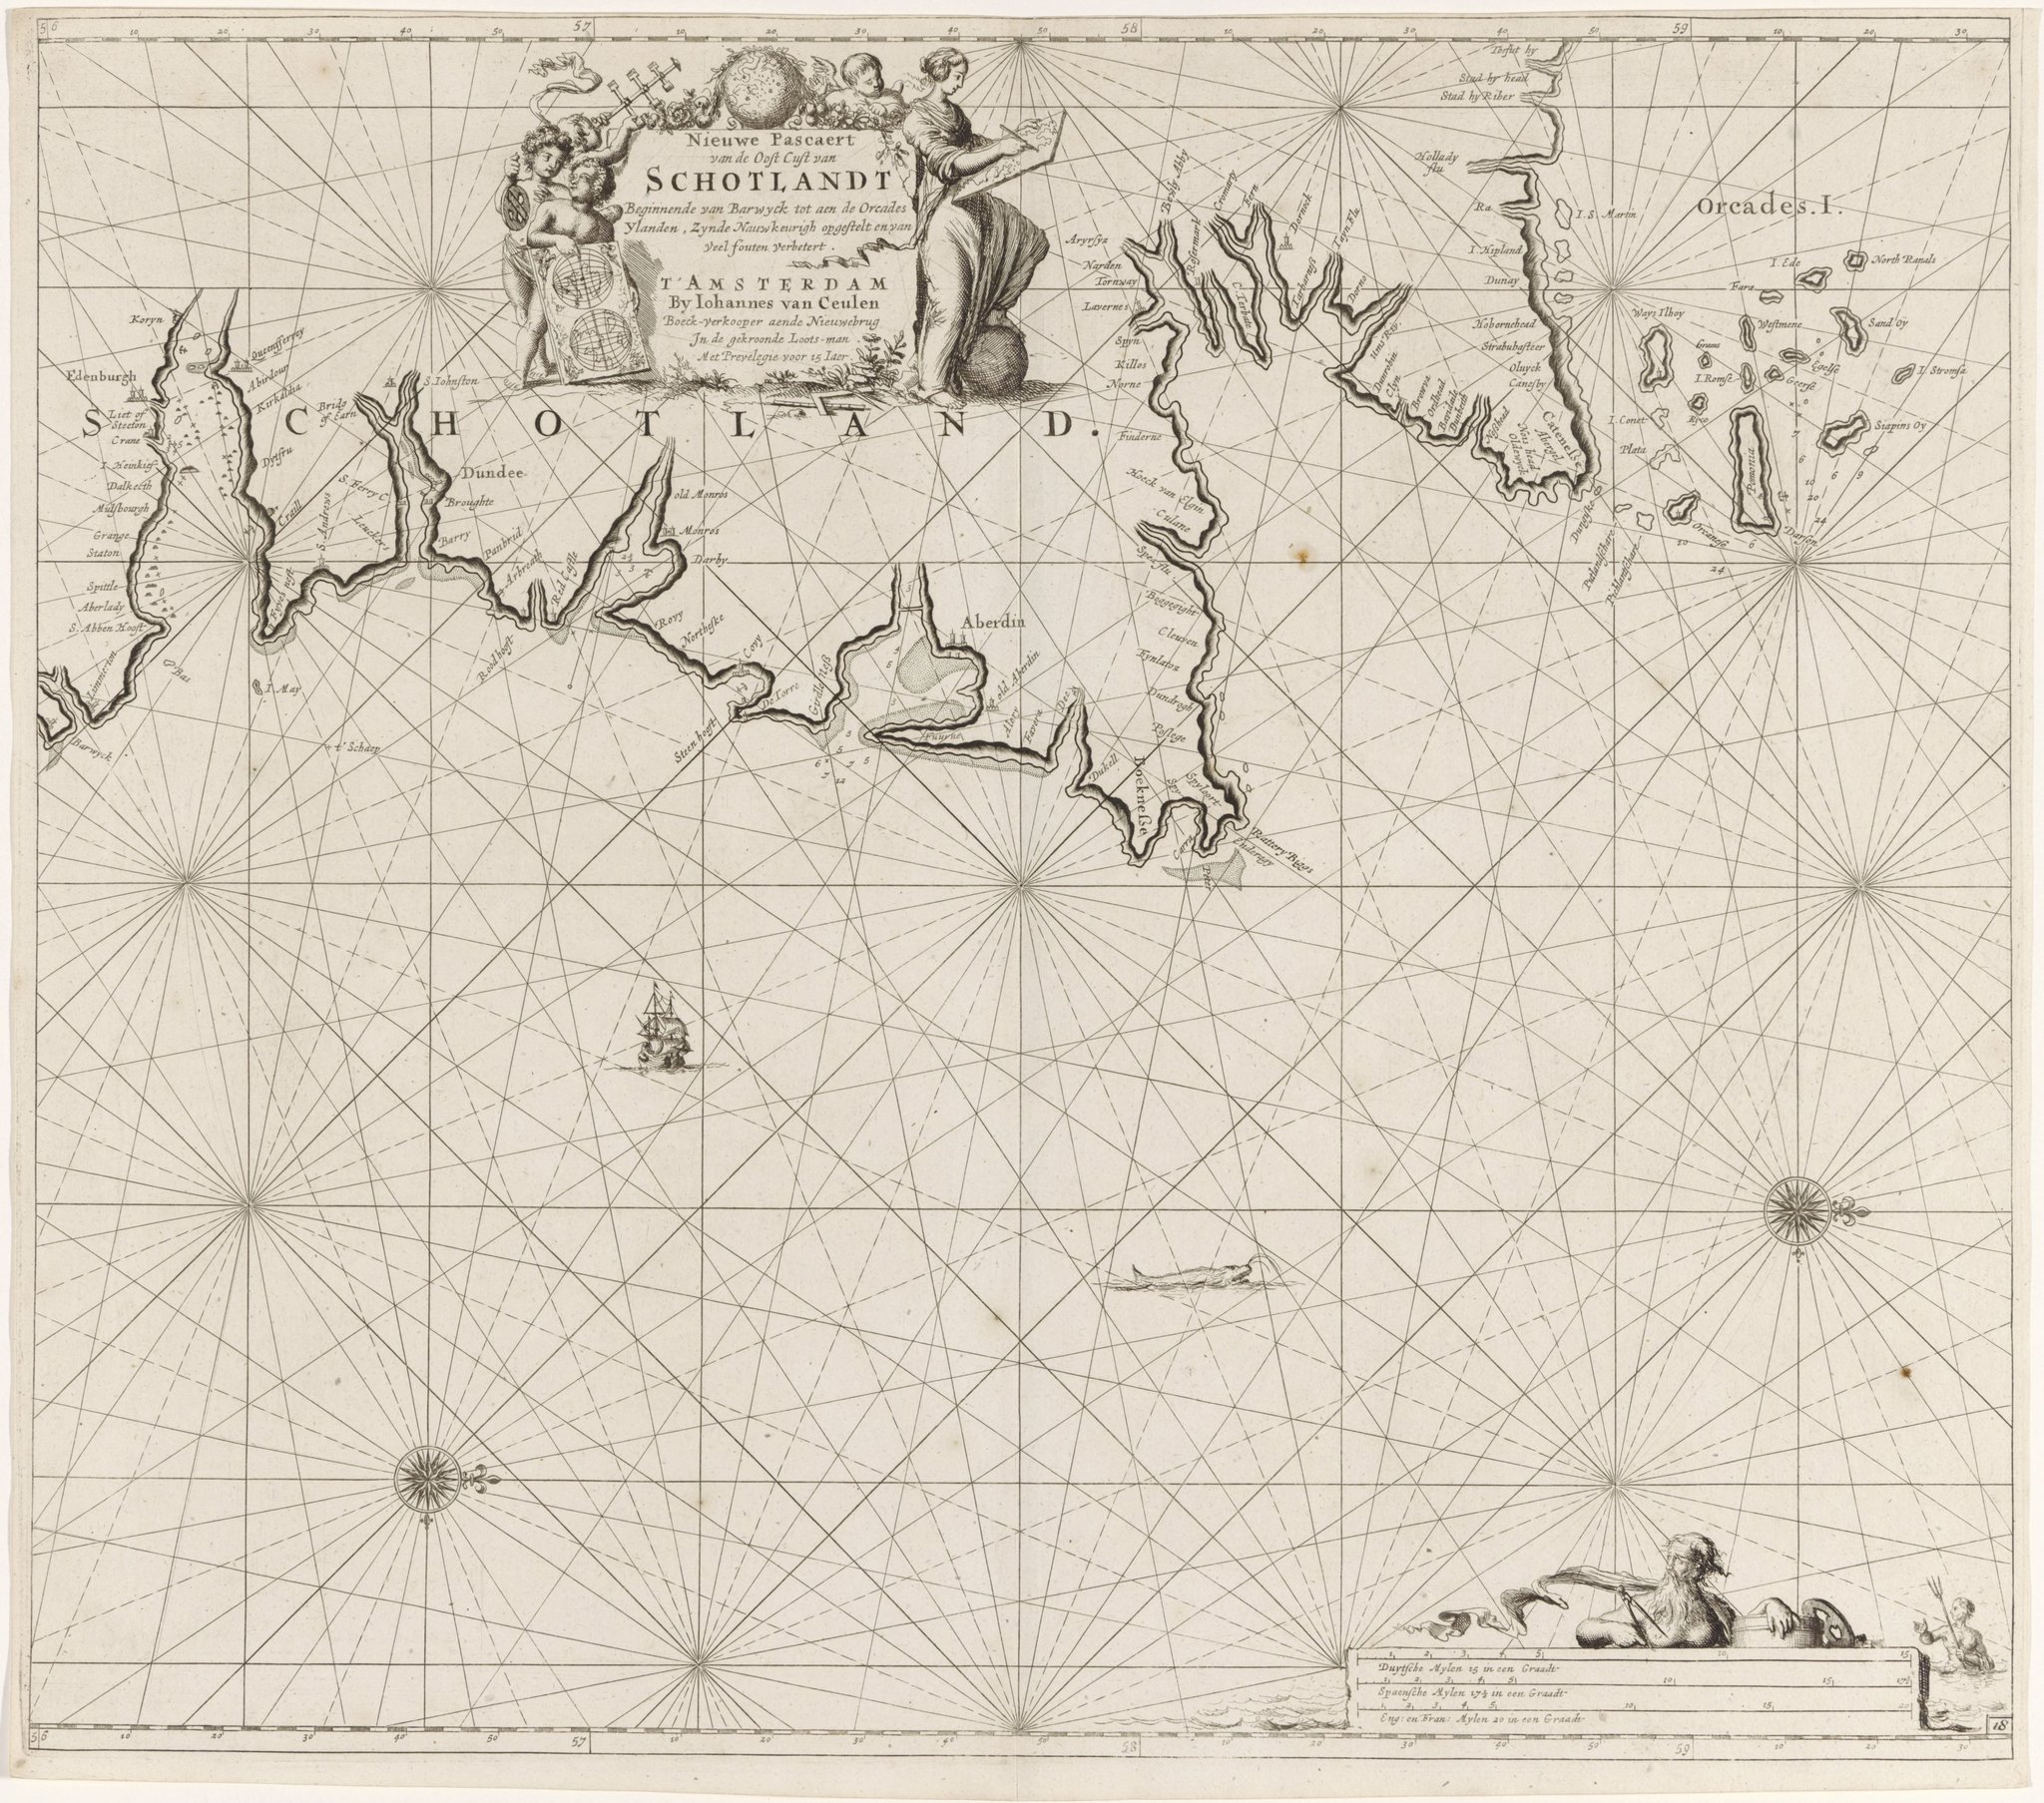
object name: print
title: Nieuwe Pascaert van de Oost Cust van Schotlandt Beginnende van Barwyck tot aen de Orcades Ylanden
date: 1681-1799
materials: paper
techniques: engraving, etching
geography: amsterdam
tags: maps, atlases, parts of ship's exterior: rudder, cupids: 'amores', 'amoretti', 'putti', position-finding at sea; nautical instruments, swimming mammals: whale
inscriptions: collector's mark: Lugt 2228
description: Paskaart van een gedeelte van noordoostkust van Schotland en de Orkney Eilanden, met twee kompasrozen, het Noorden ligt rechts. Bovenaan een cartouche met de titel en het adres van de uitgever geflankeerd door putti met kaarten en nautische instrumenten en een vrouw die een kaart tekent. Rechtsonder de schaalverdeling in Duitse, Spaanse en Engelse of Franse mijlen (schaal: c. 1:700.000), waarbij twee zeegoden.